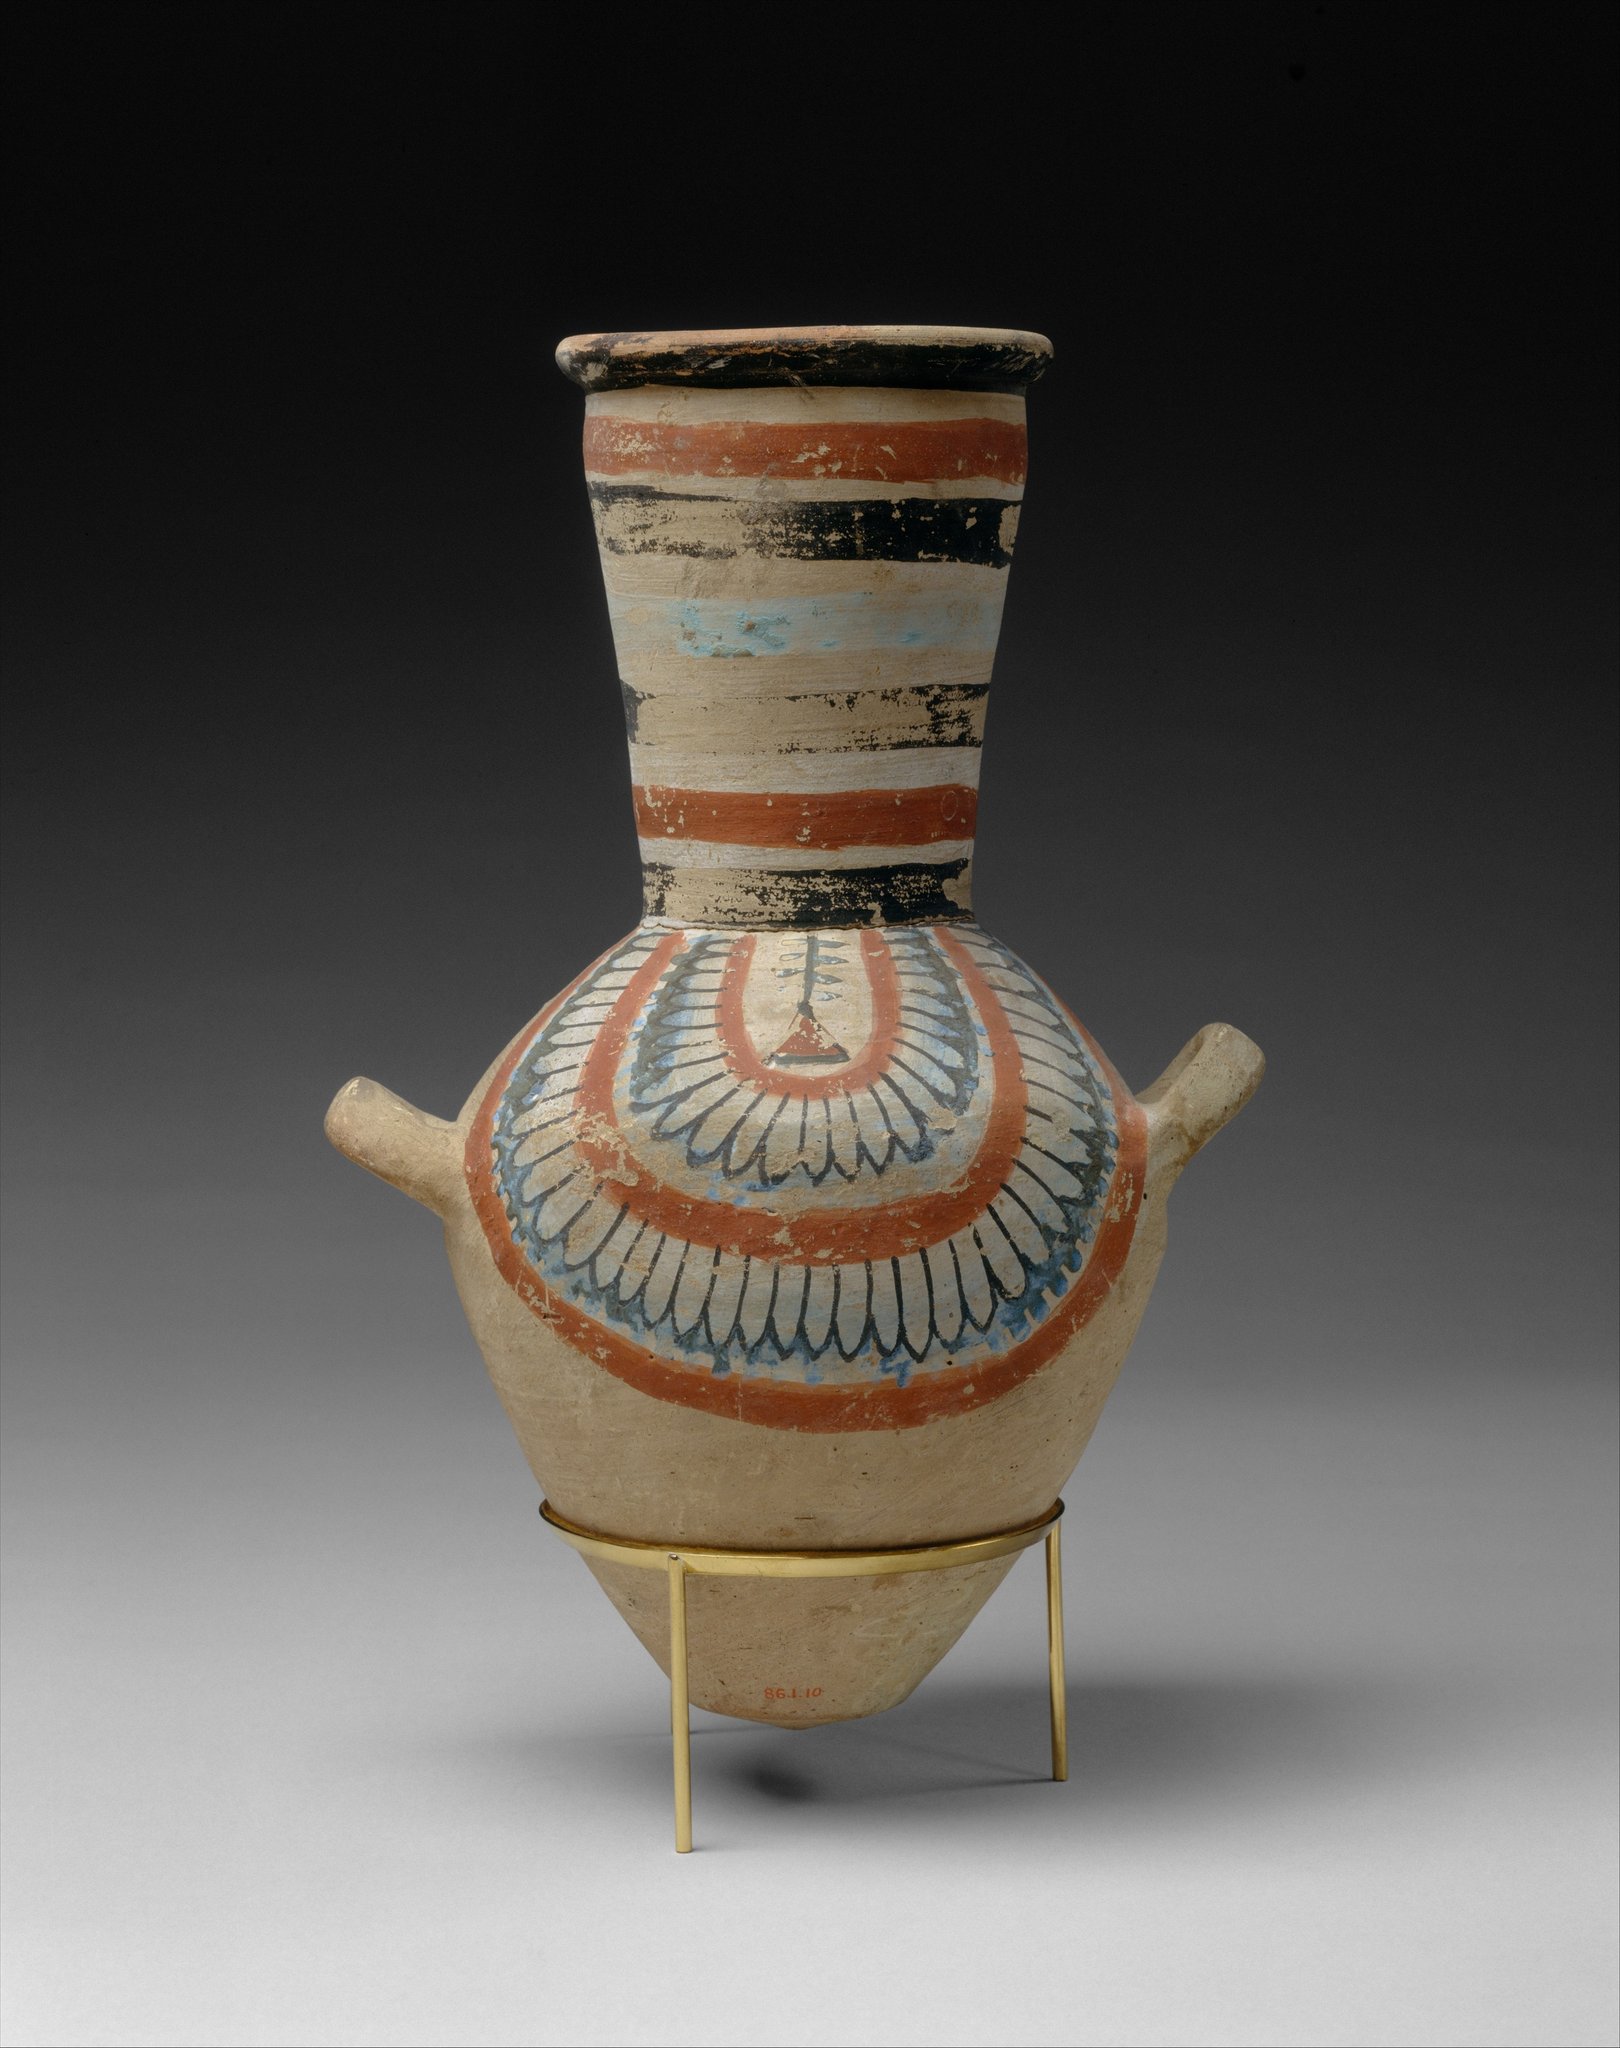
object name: jar, wine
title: Jar from the tomb of Sennedjem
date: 1279-1213 BCE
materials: pottery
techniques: painting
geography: egypt